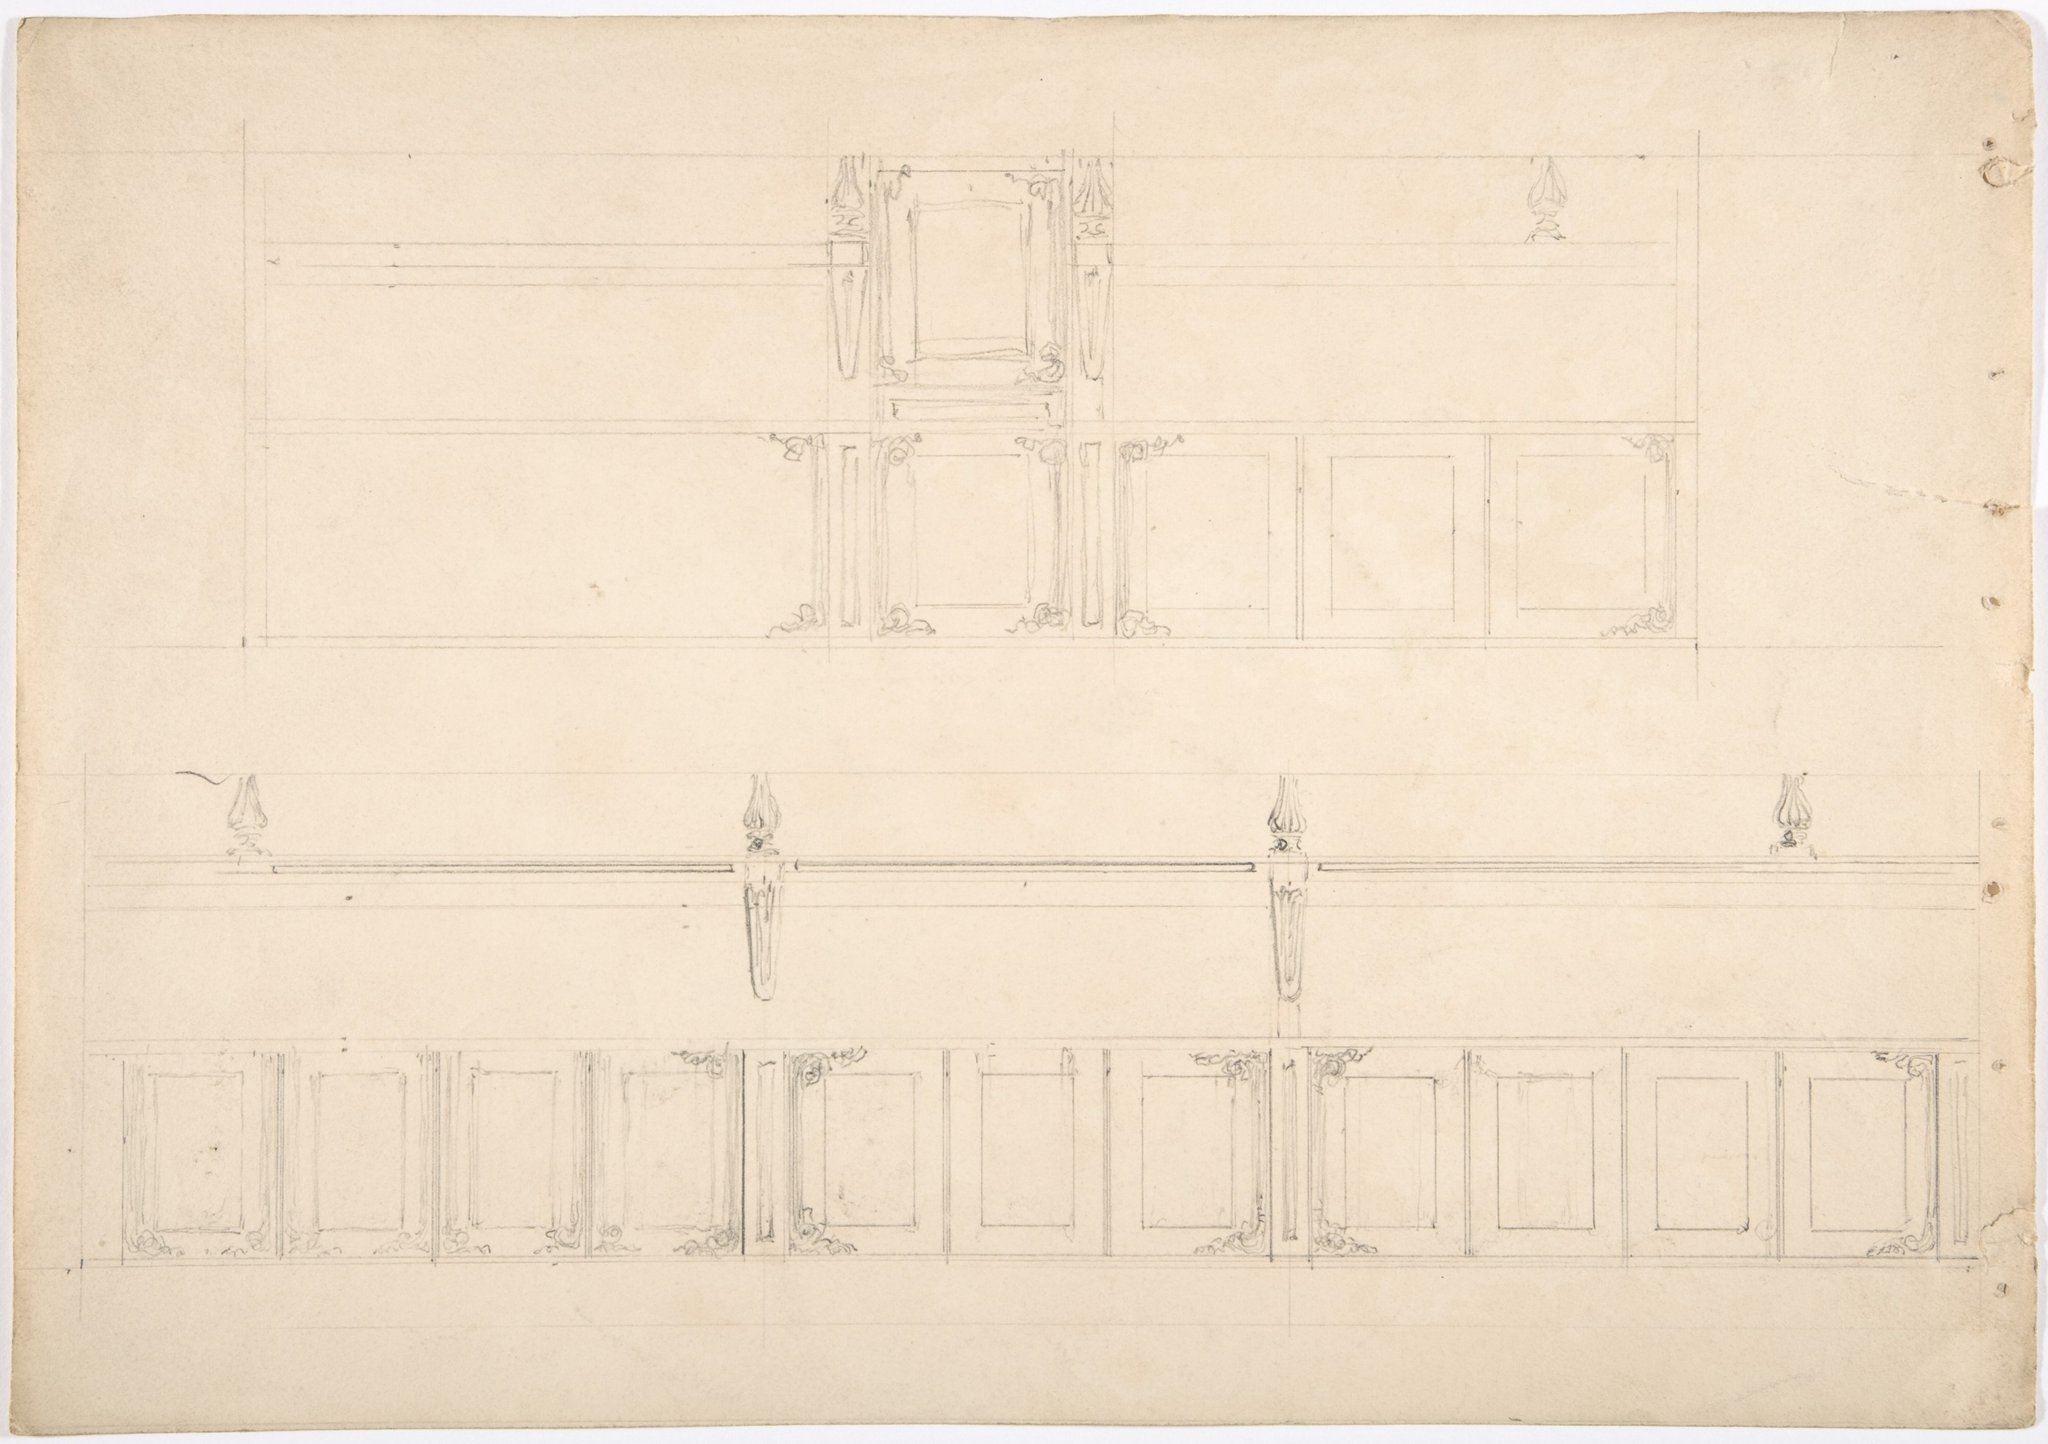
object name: drawing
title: Paneling and Benches (Verso: sketch of a Desk)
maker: anonymous, british, 19th century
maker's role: artist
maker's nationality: british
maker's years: 1800-1900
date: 1830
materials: graphite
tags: architecture